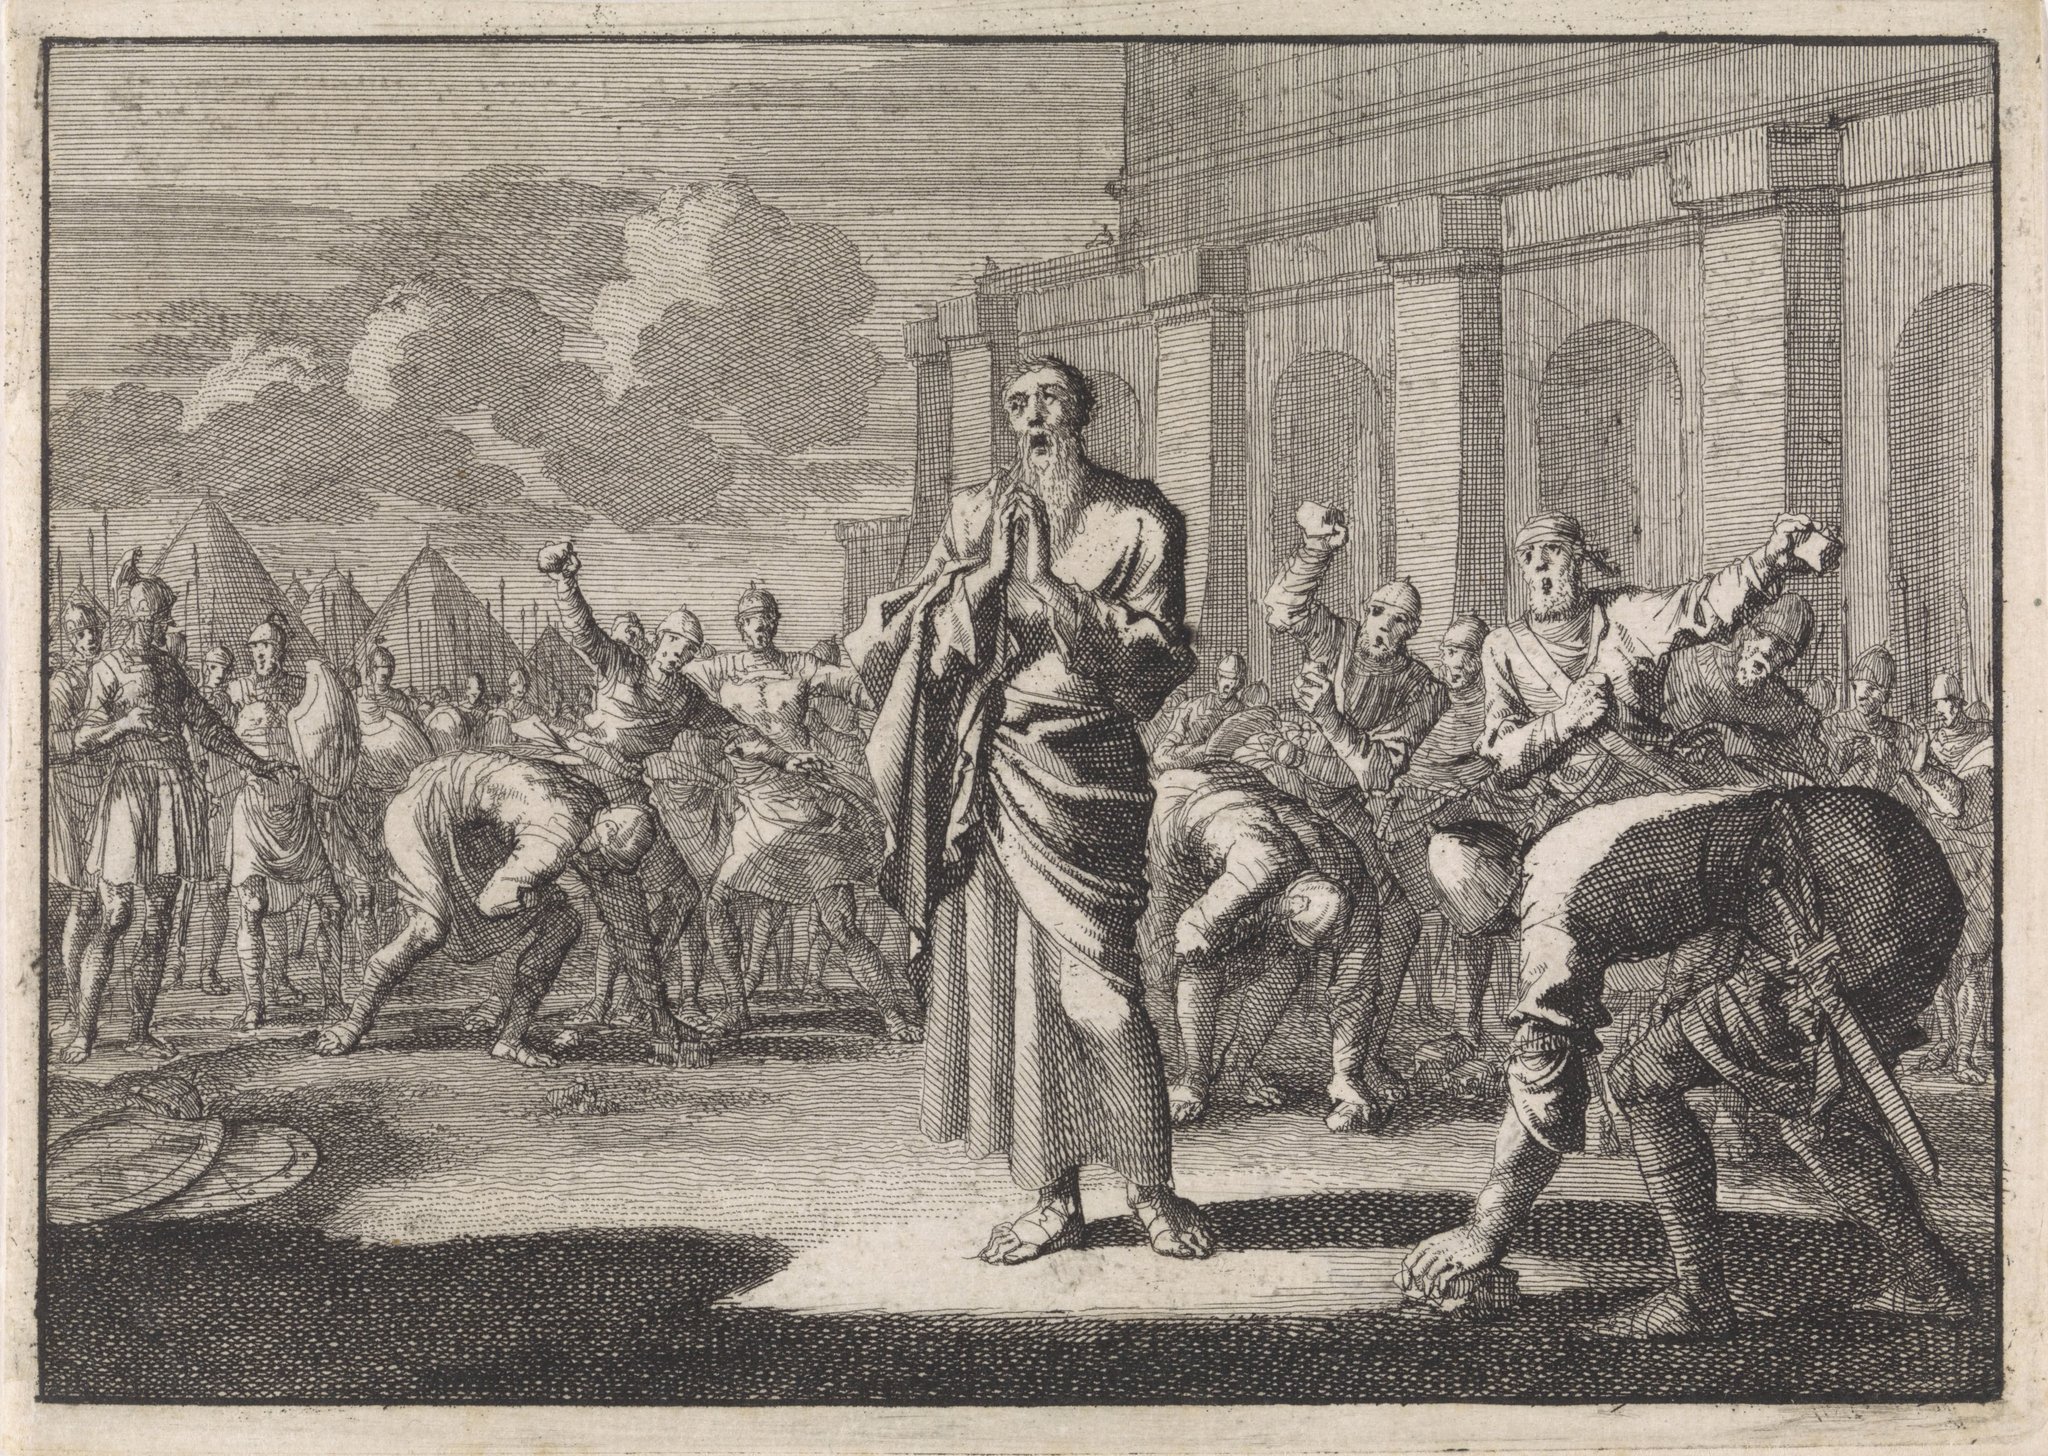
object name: print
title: Onias gestenigd door Joden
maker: jan luyken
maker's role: draughtsman, print maker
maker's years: 1649-1712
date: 1704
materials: paper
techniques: etching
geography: amsterdam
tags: onias, the high priest, is slandered (2 maccabees 4:1-4, 4:34-38)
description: Prent ook gebruikt als boekillustratie in: Josephus, Flavius. Alle de Werken, 2 delen. Amsterdam: Pieter Mortier, 1704, dl. 1, p. 334.